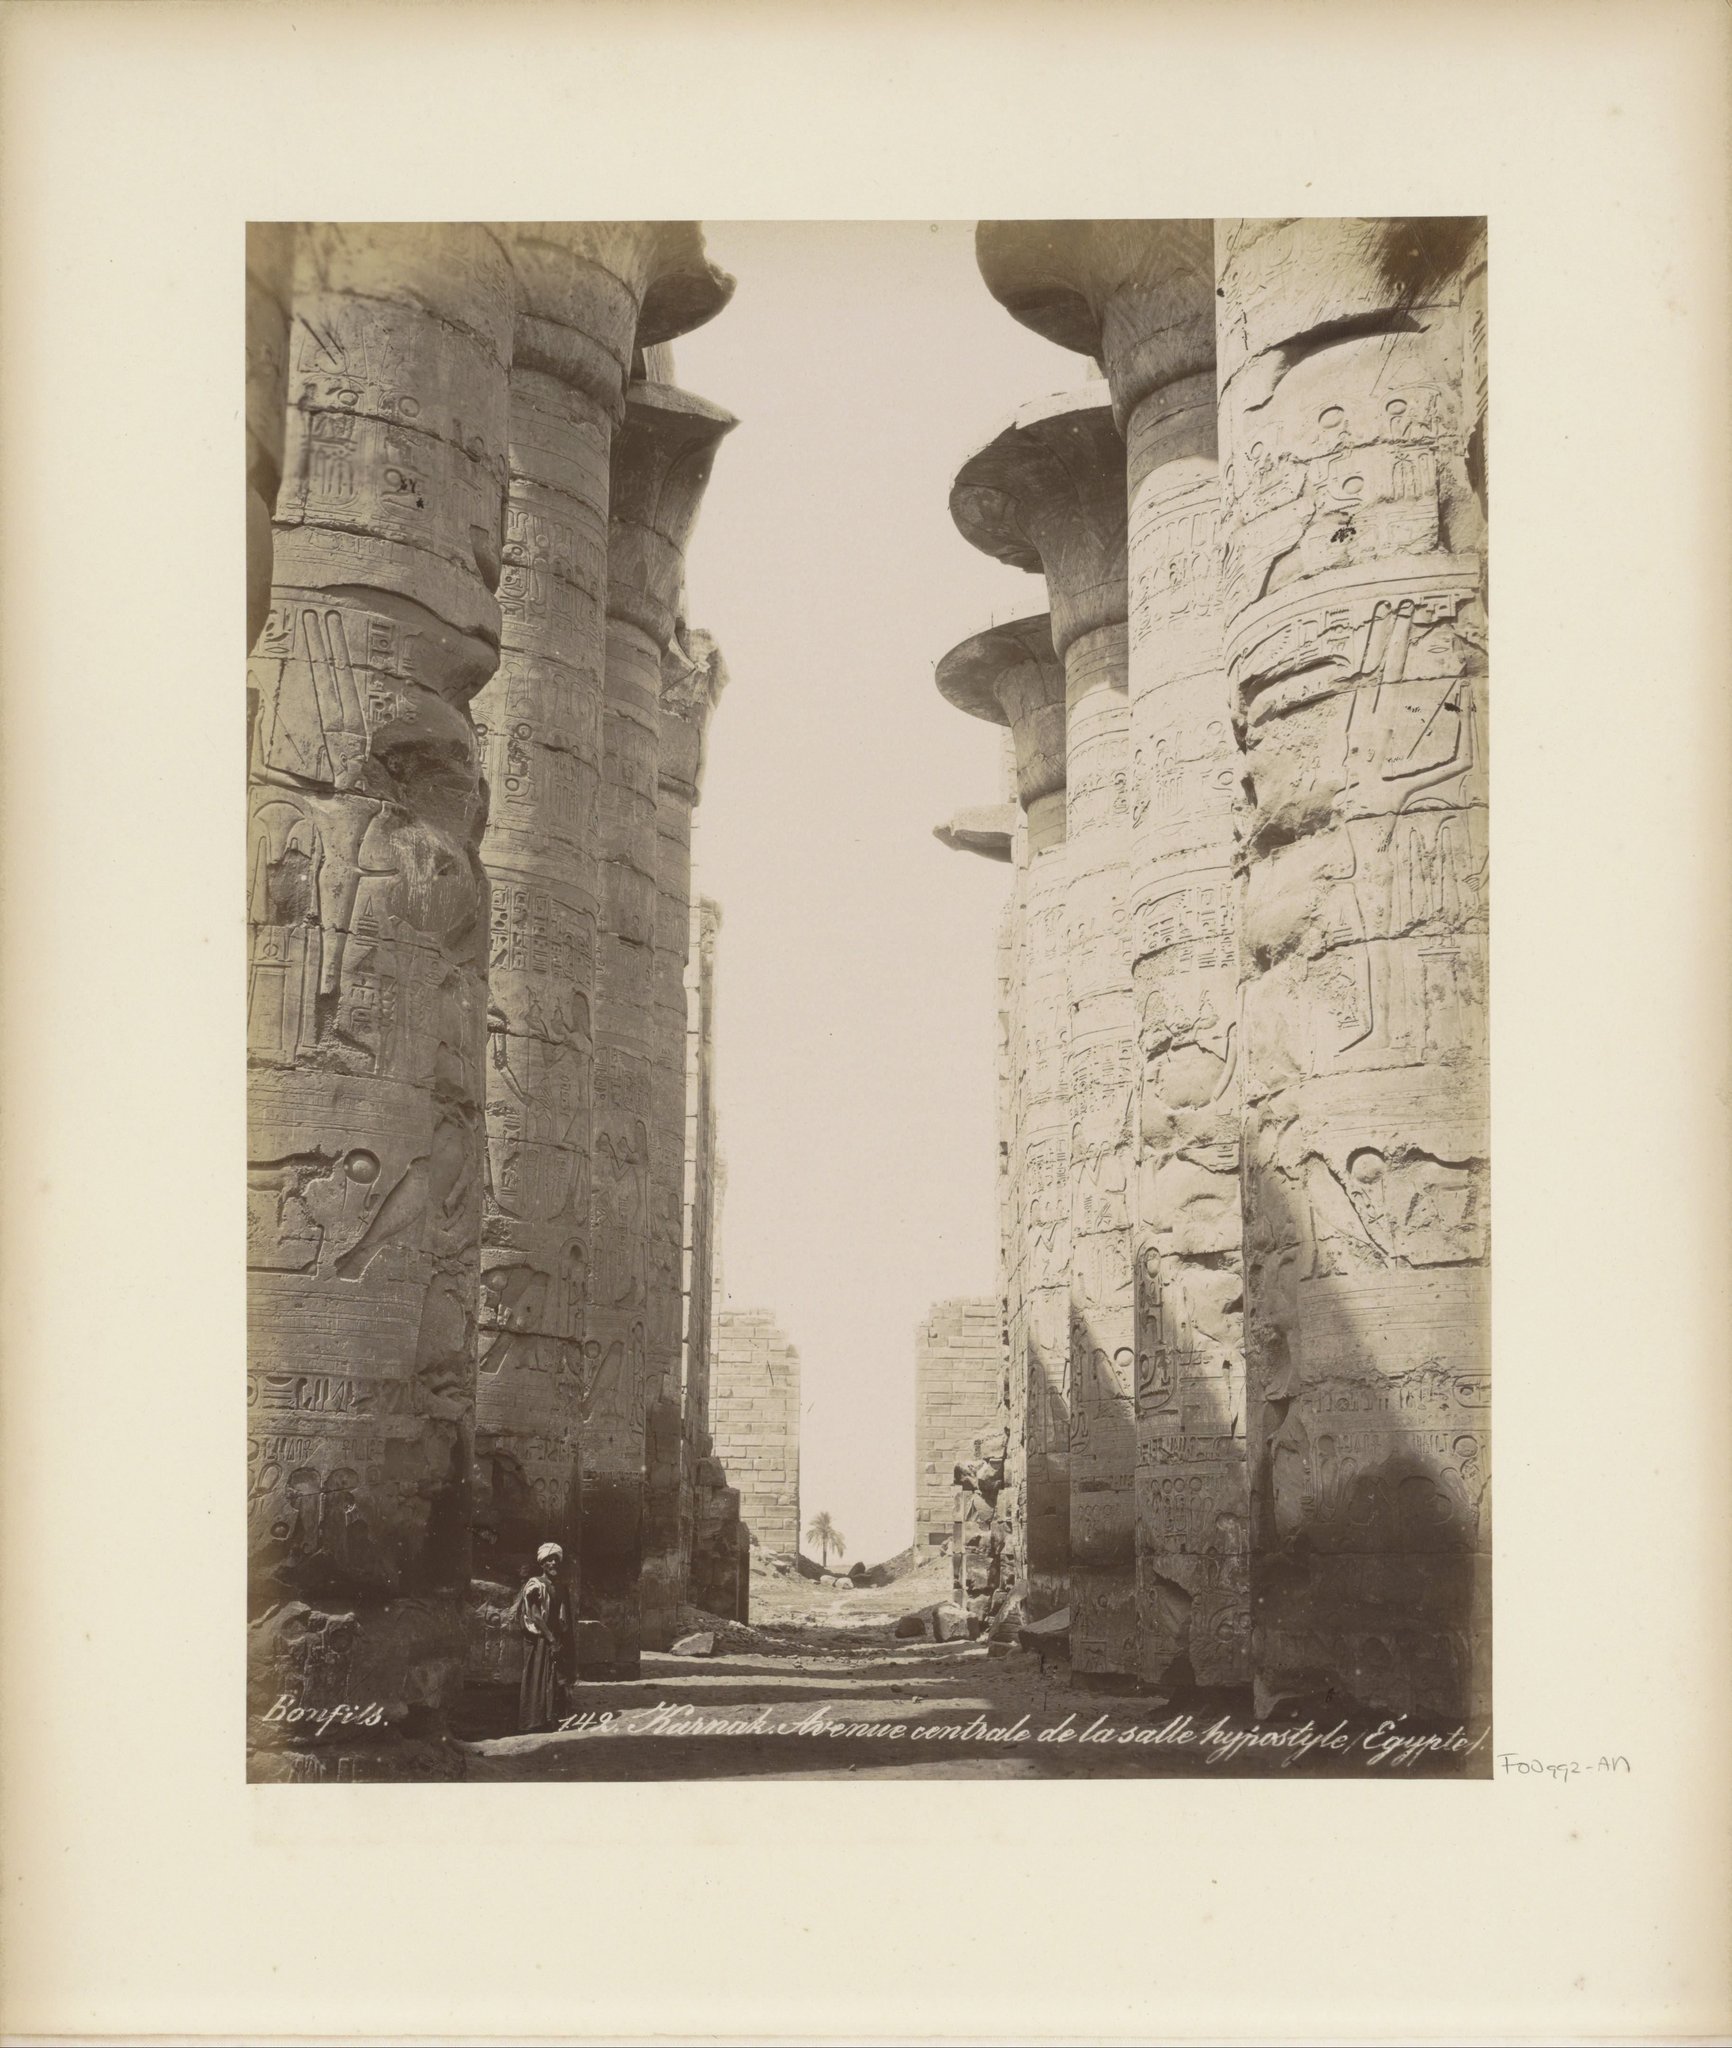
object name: photograph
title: Zuilen met hiërogliefen van de grote zaal (hypostylezaal) in de Tempel van Karnak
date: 1870-1898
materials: cardboard, paper, photographic support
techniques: albumen print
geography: karnak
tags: temple, shrine ~ egyptian religion, egyptian hieroglyphs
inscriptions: negative number: ‘142’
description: Onderdeel van Reisalbum met 80 foto's van Egypte.